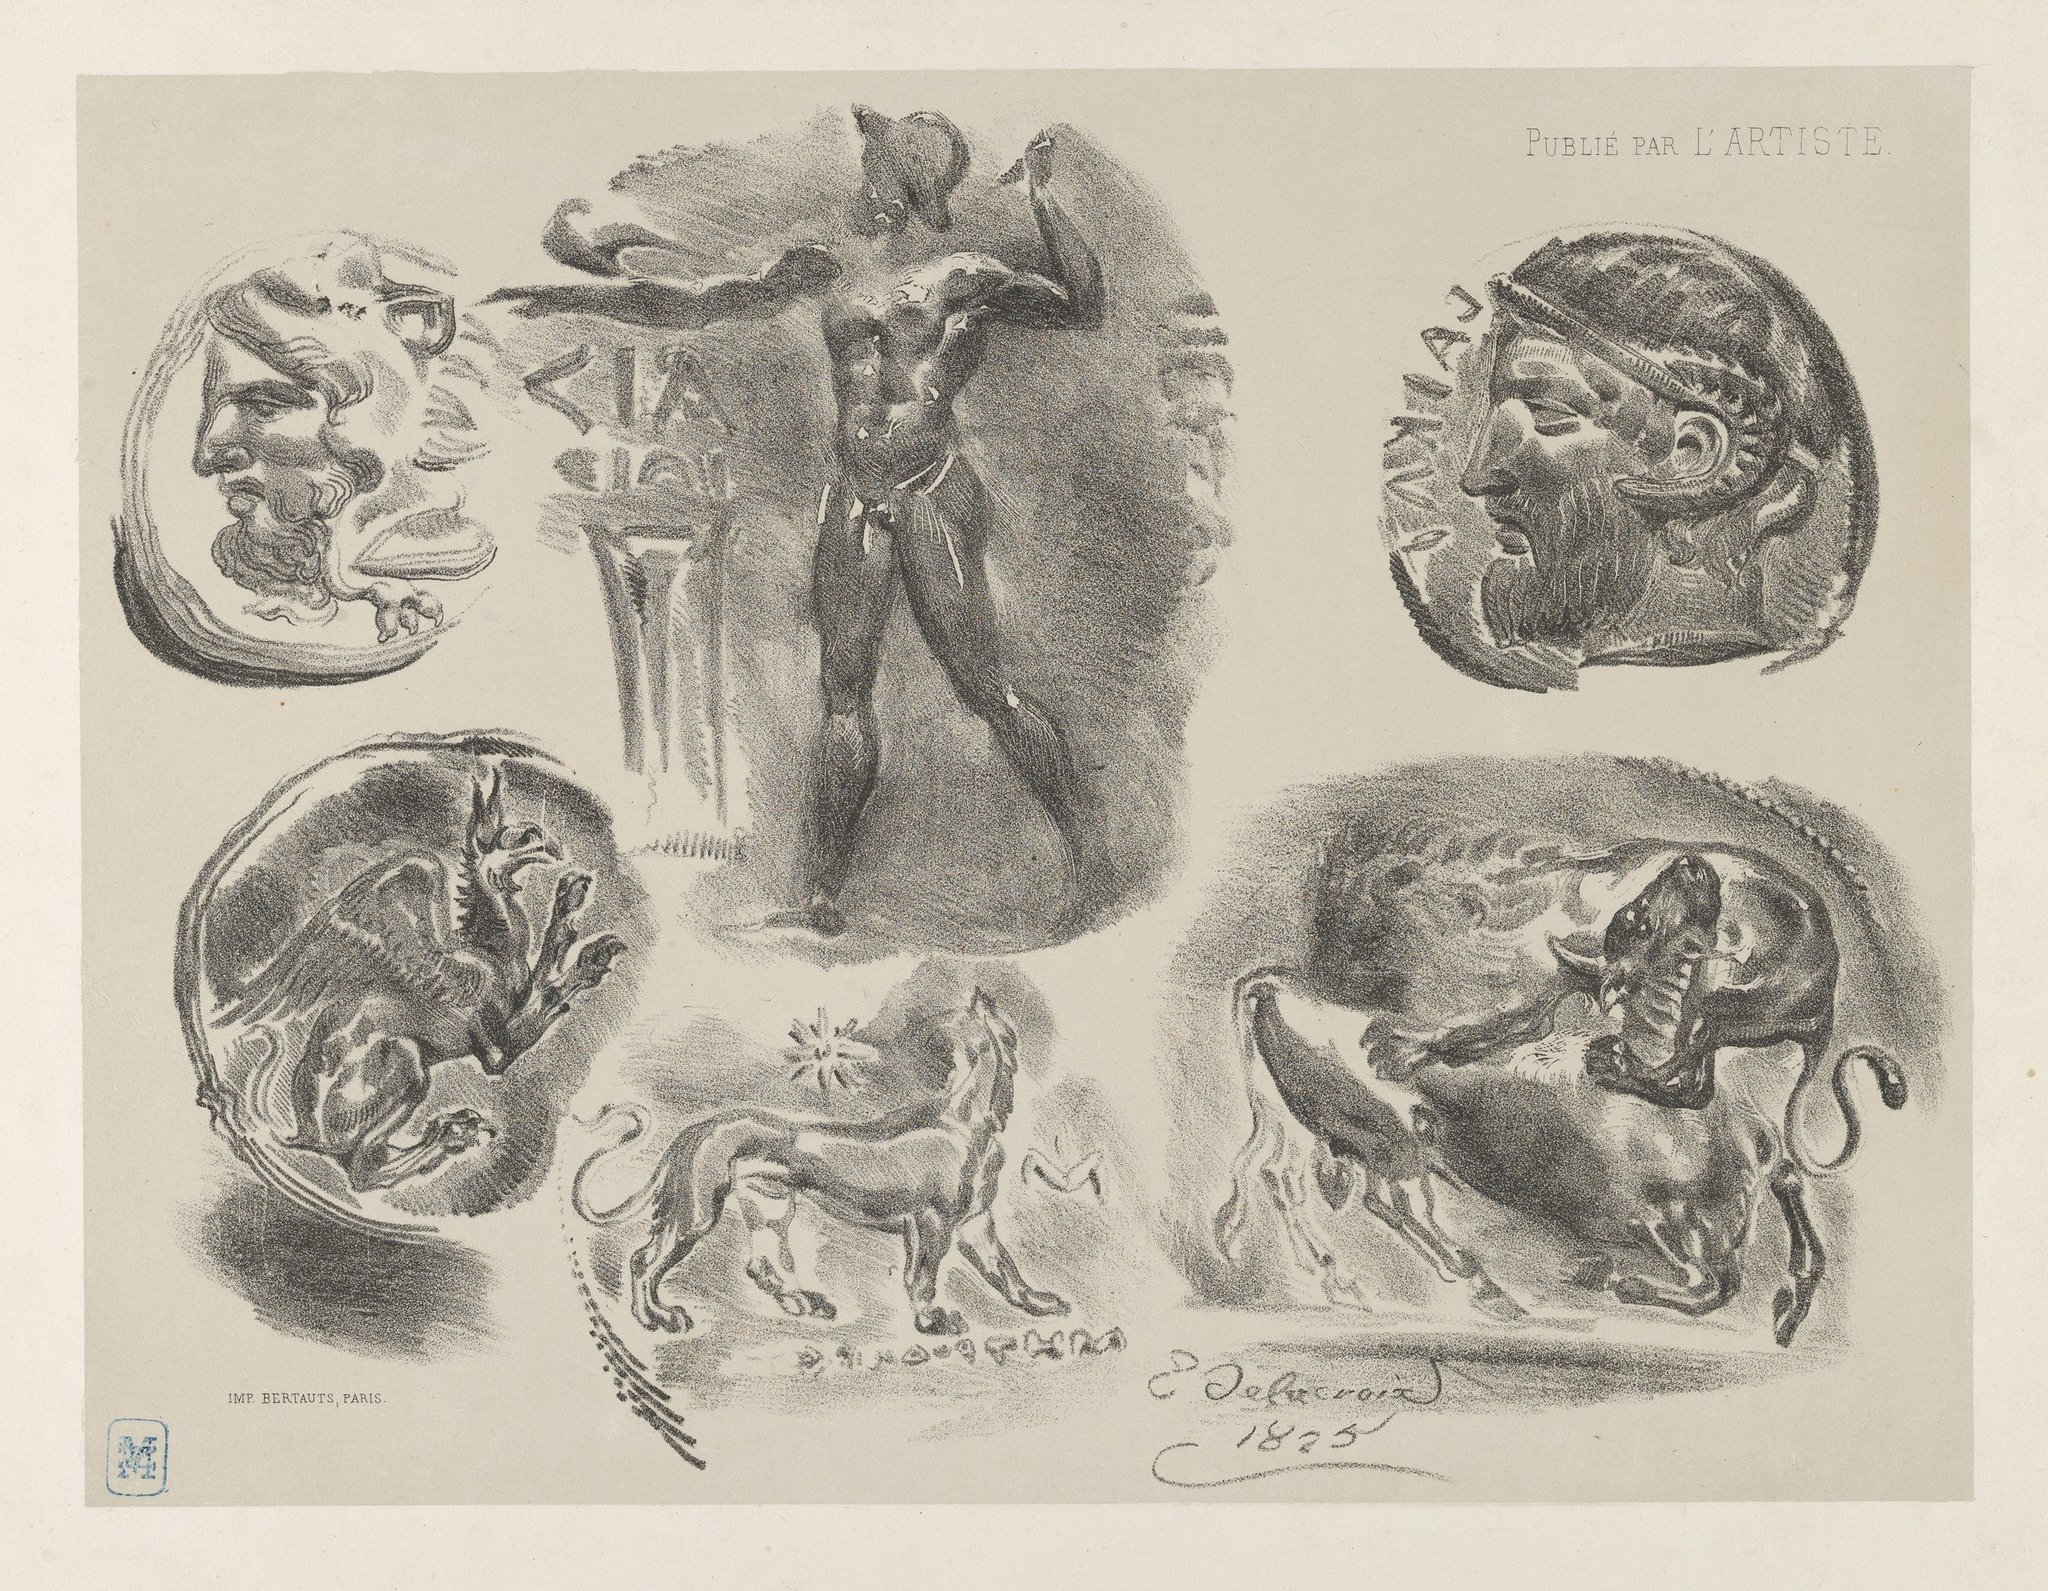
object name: print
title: Studies of Six Greek Coins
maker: eugène delacroix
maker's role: artist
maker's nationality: french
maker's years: 1798-1863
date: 1825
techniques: lithograph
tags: human figures,animals,profiles,griffins,coins